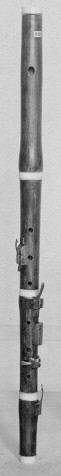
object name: transverse flute in d or c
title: Transverse Flute In D or C:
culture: german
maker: c.f. starck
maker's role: maker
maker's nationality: german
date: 1800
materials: brass, ivory, wood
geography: germany